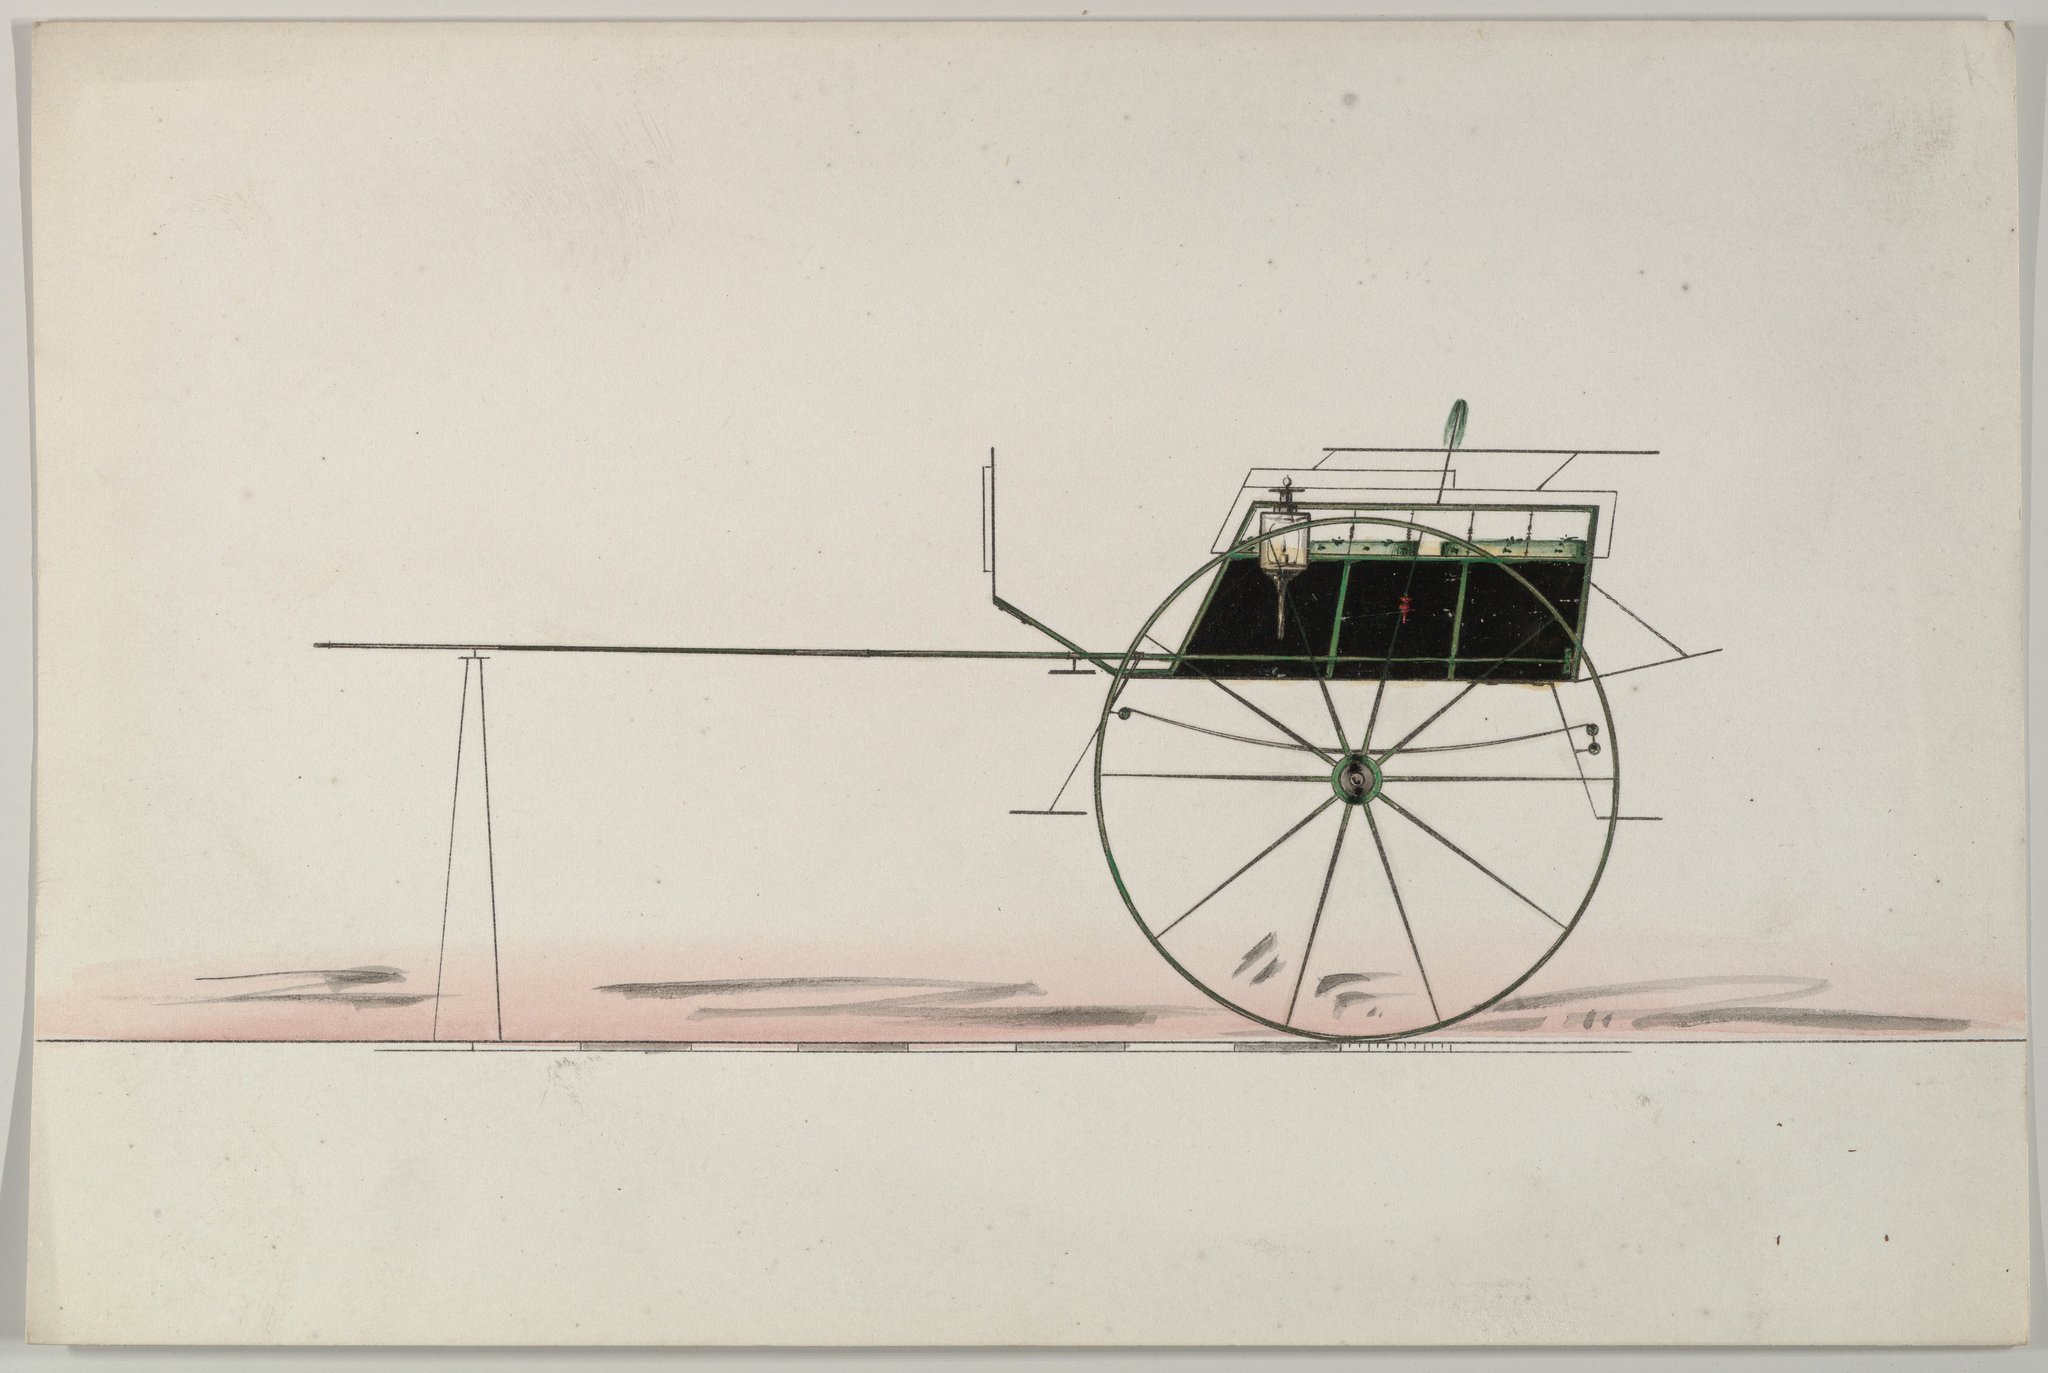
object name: drawing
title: Dog Cart/Tandem Cart (unnumbered)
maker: brewster & co.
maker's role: manufacturer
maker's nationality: american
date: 1850-1874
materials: gouache, gum arabic, ink, watercolor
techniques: pen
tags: carriages